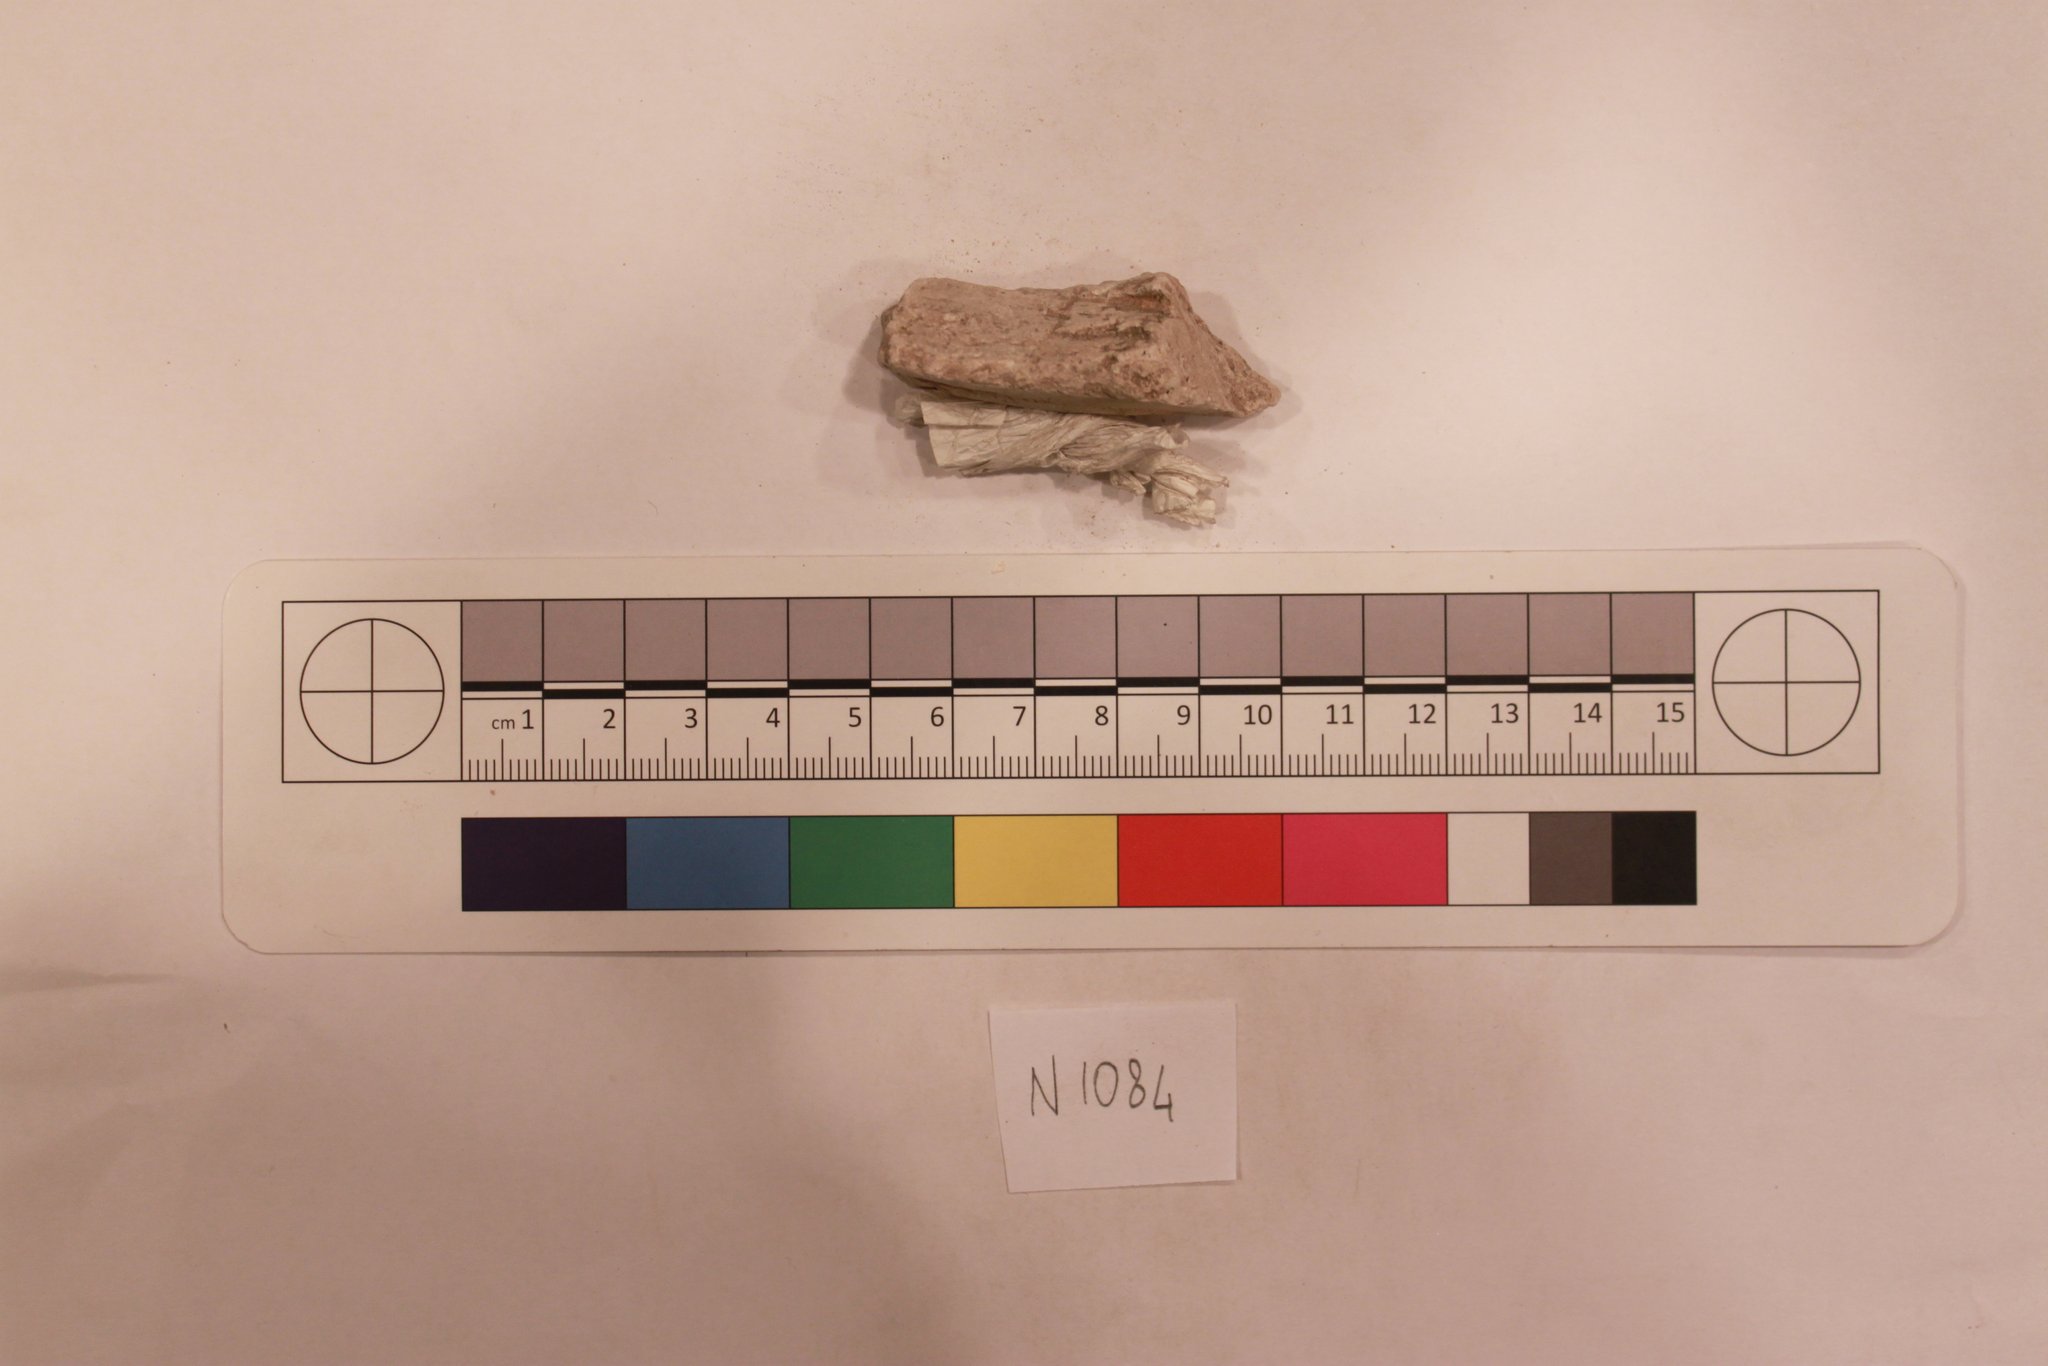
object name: fragment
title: Stucco Fragment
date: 701-1200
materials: plaster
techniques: carving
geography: iran